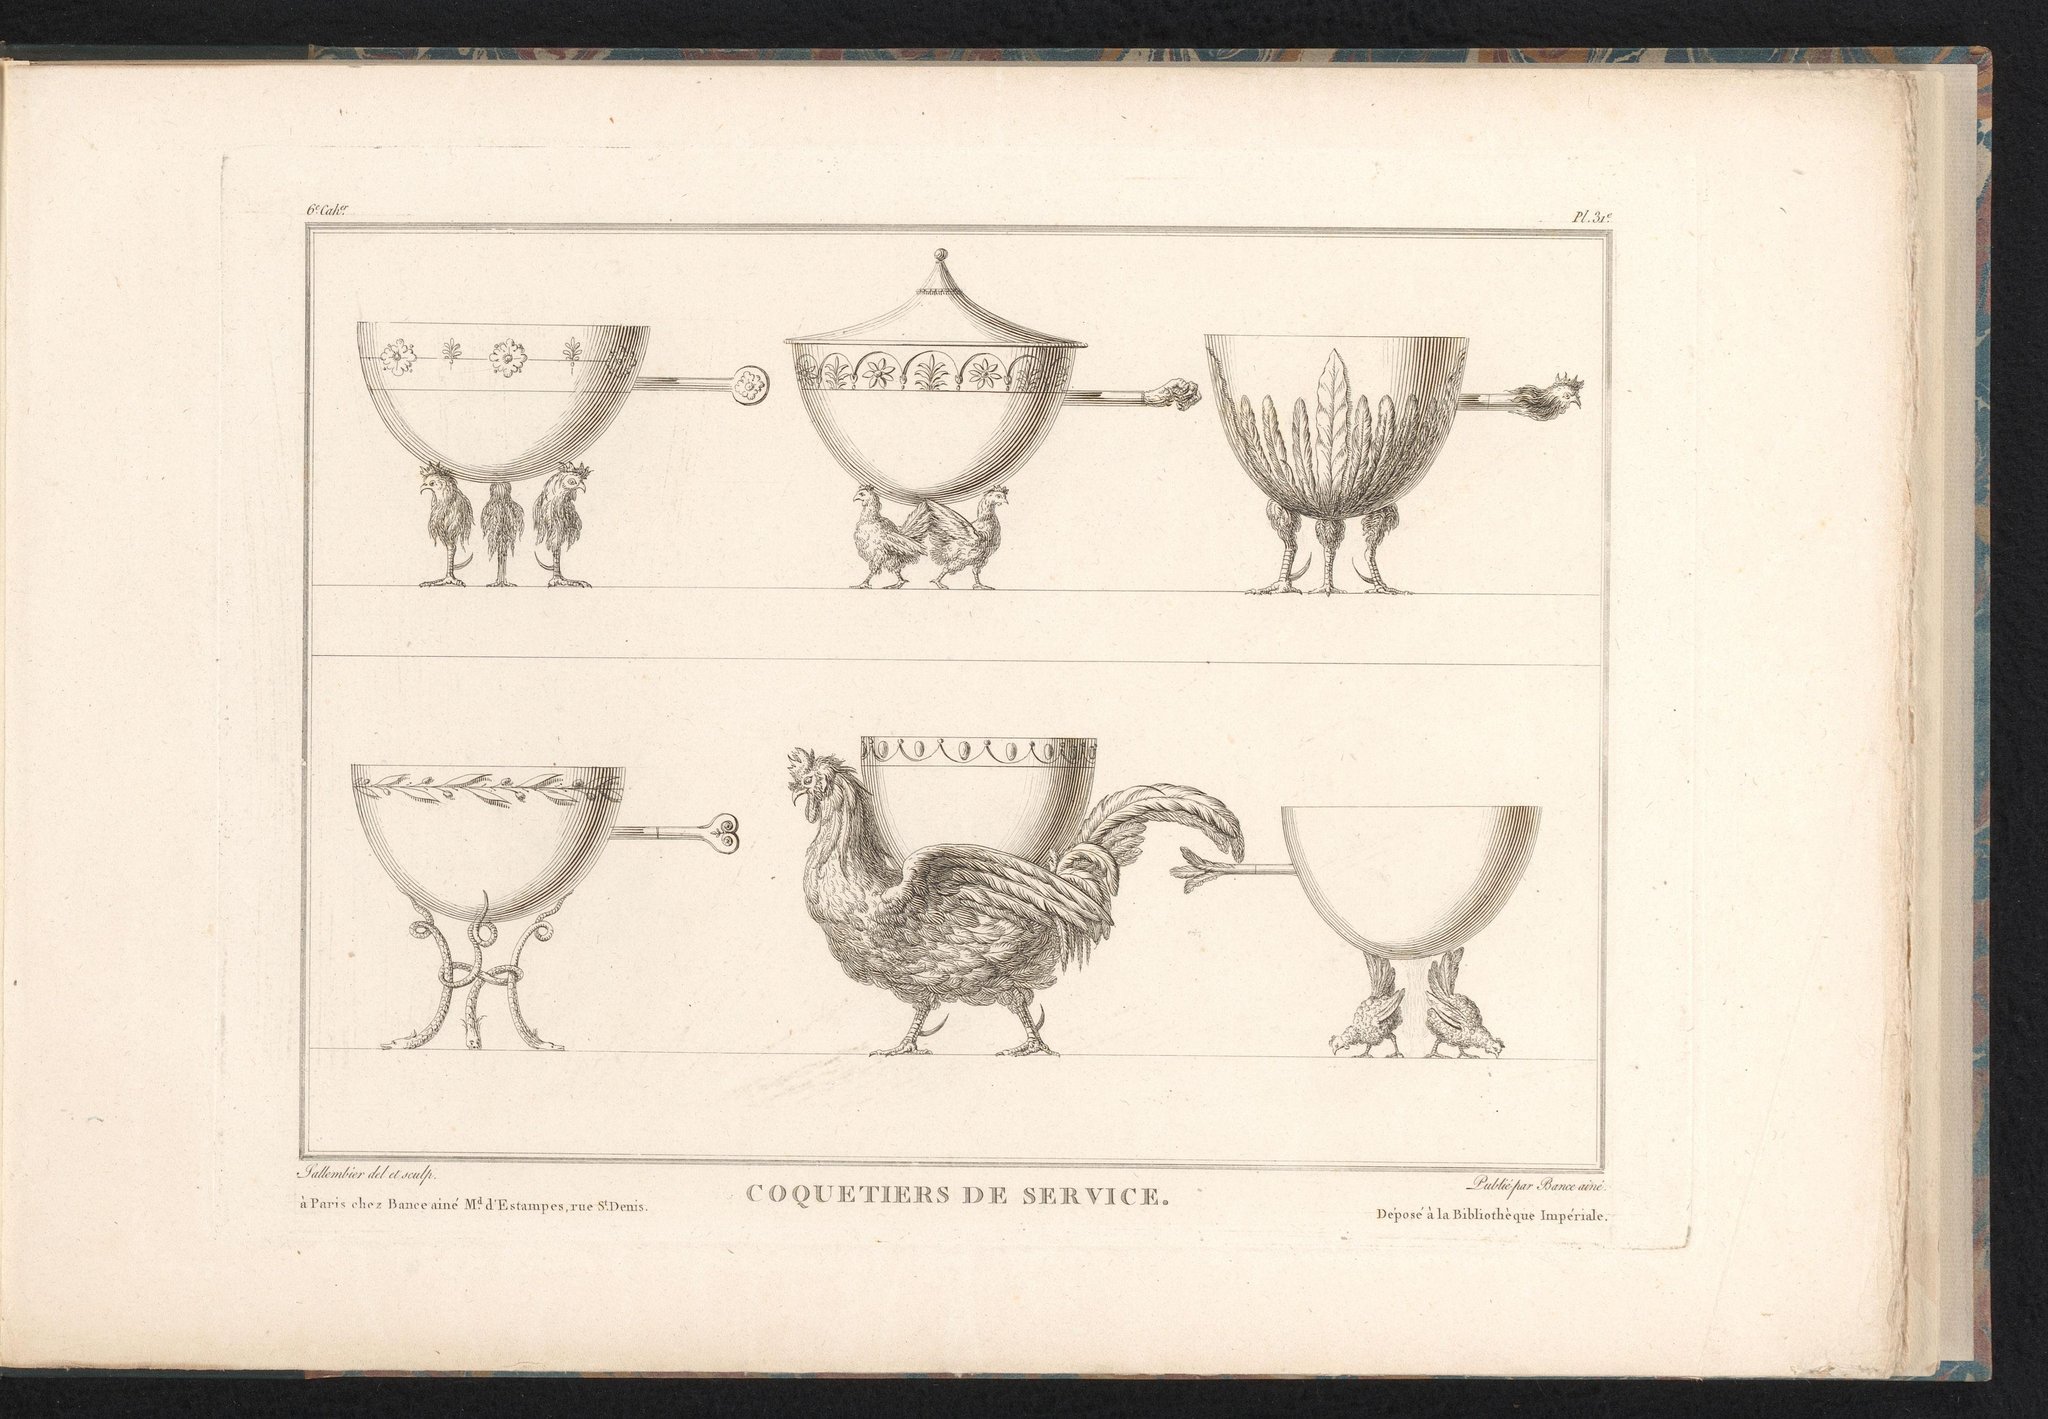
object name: ornament print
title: Modèles d'Orfèvrerie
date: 1805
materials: paper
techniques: etching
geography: paris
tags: egg-cup, fowl (cock, hen, chicken, etc.)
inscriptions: : ‘Déposé à la Bibliothèque Impériale’, number: ‘6.e Cah.er’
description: Ontwerpen voor zes eierdoppen met decoratie van kippen en hanen. Prent maakt deel uit van een album.